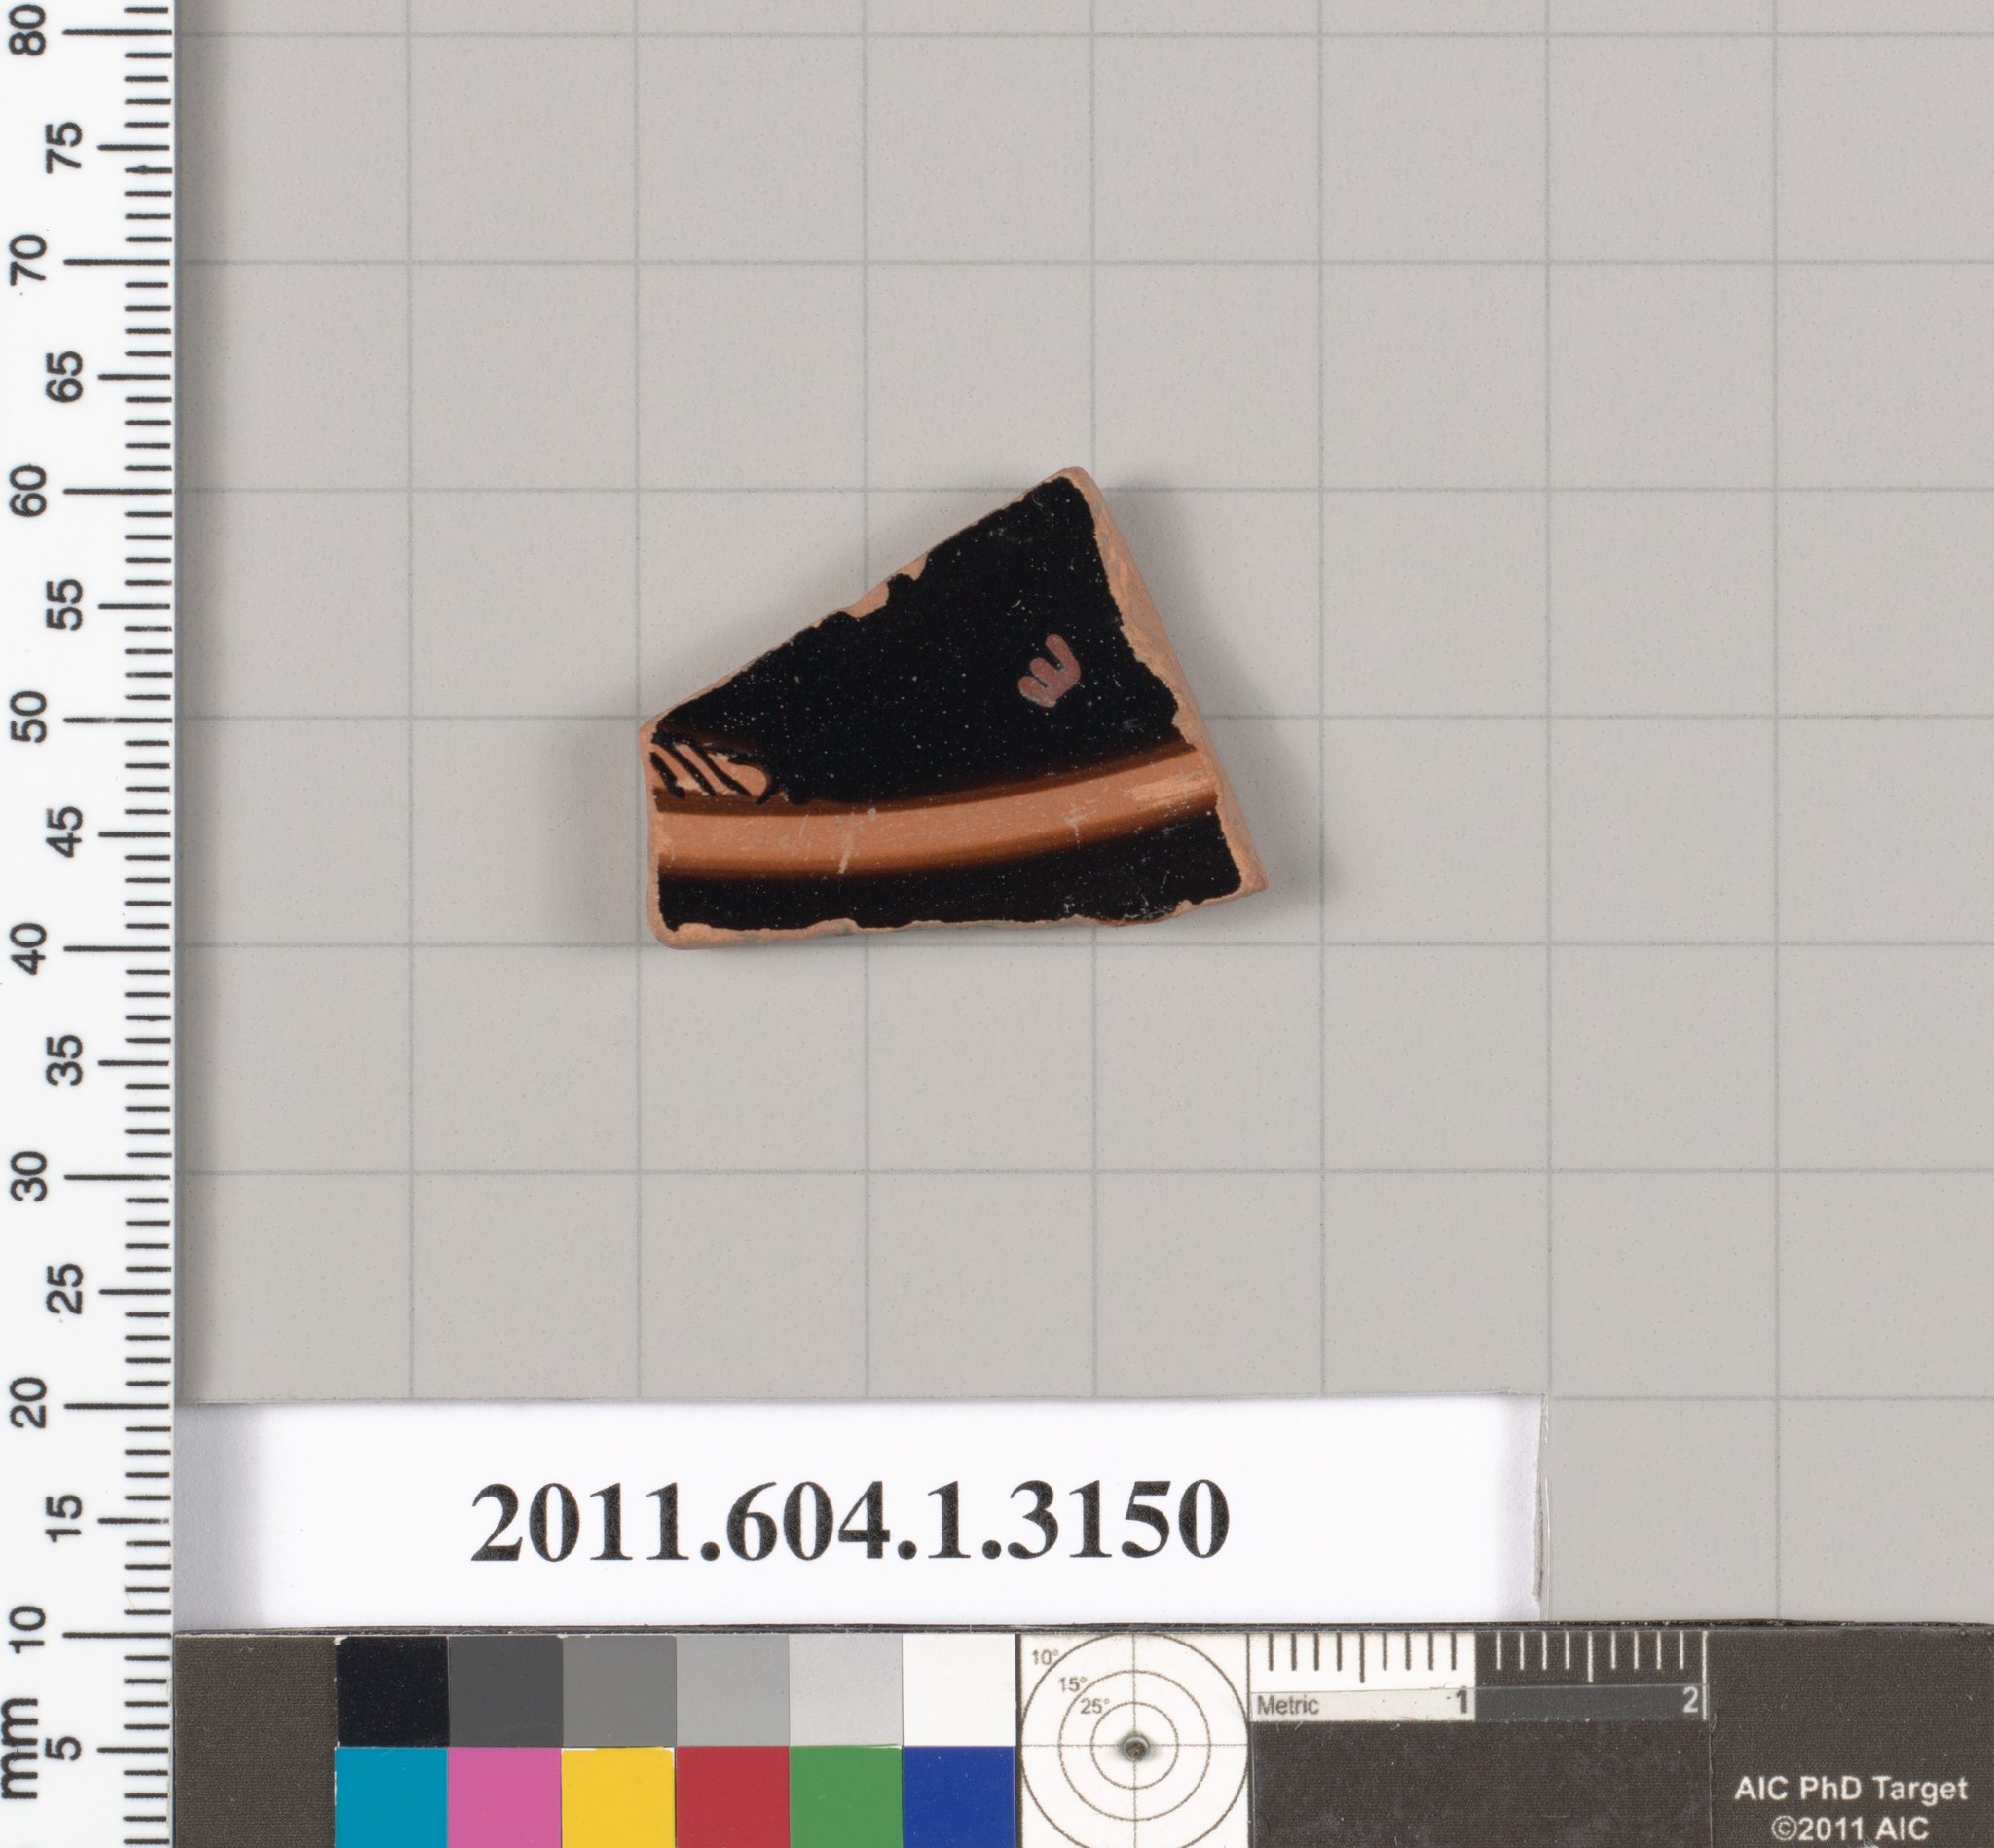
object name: kylix fragment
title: Terracotta fragment of a kylix (drinking cup)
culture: greek, attic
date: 490-480 BCE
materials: terracotta